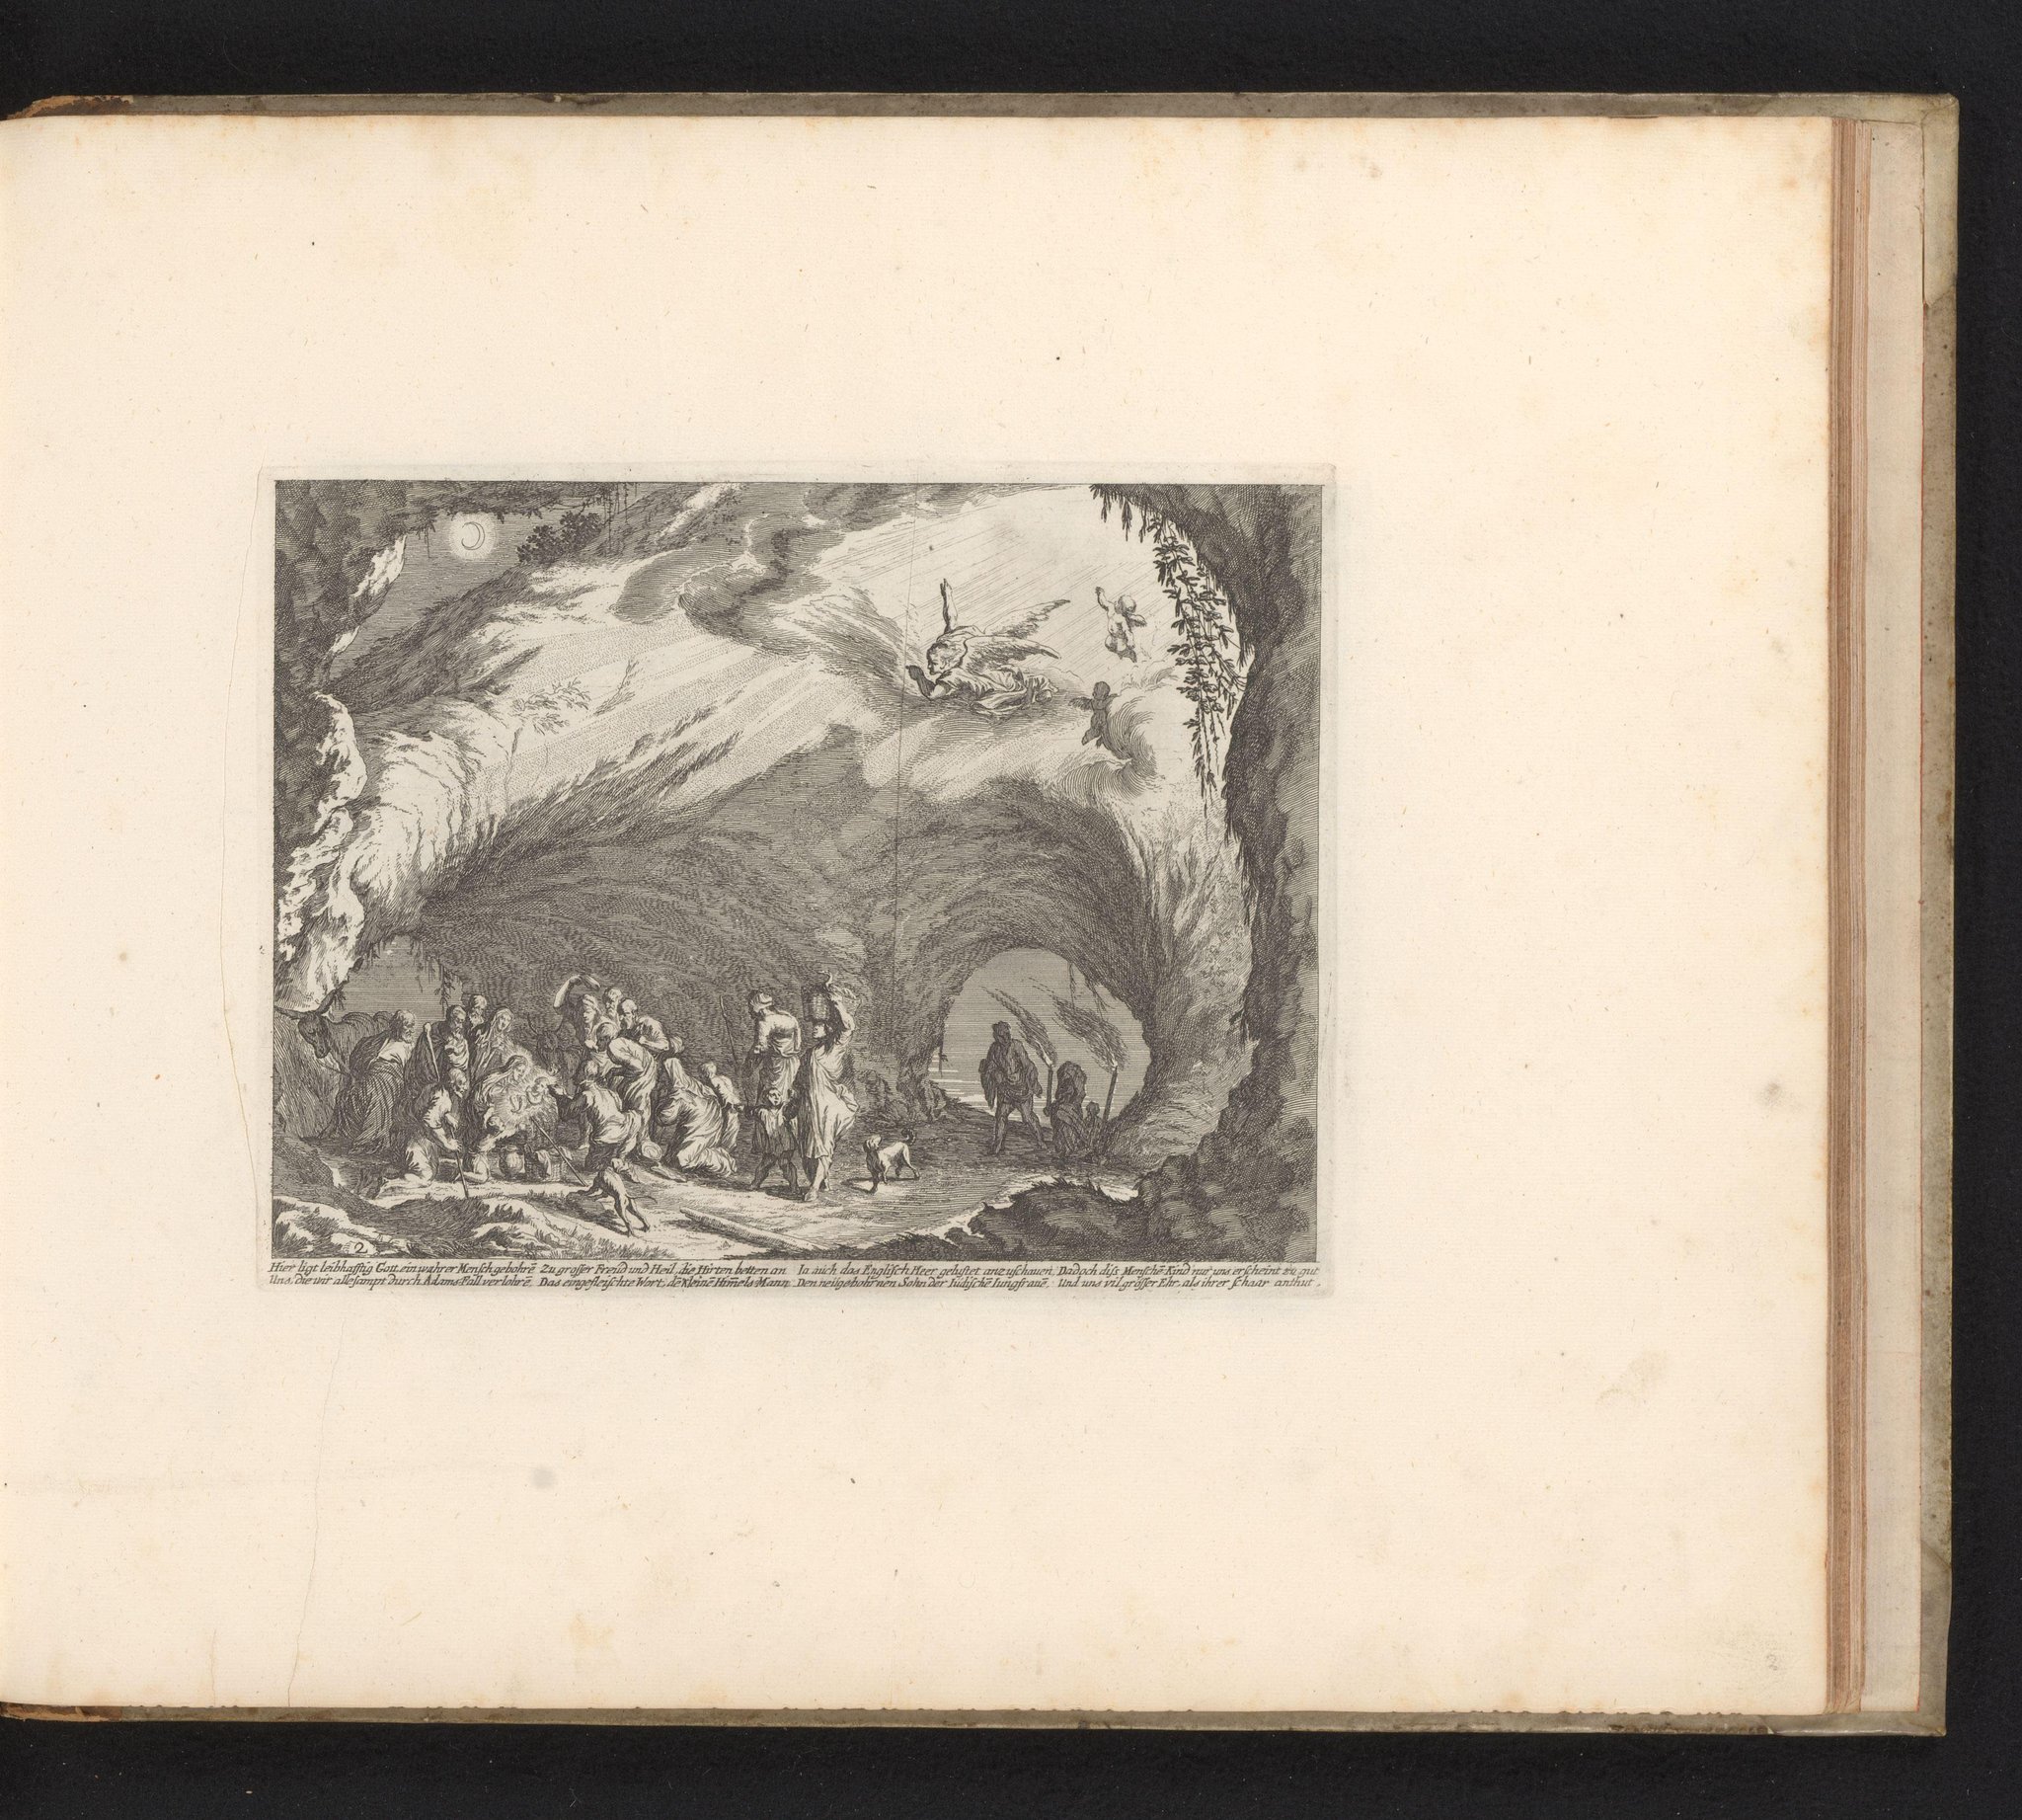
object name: album leaf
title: Aanbidding door de herders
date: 1670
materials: paper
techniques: etching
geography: augsburg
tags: adoration of the christ-child by the shepherds; mary and joseph present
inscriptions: collector's mark: Lugt 2228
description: Tekst in het Duits in de ondermarge. Linksonder genummerd: 2. Prent maakt deel uit van een album.